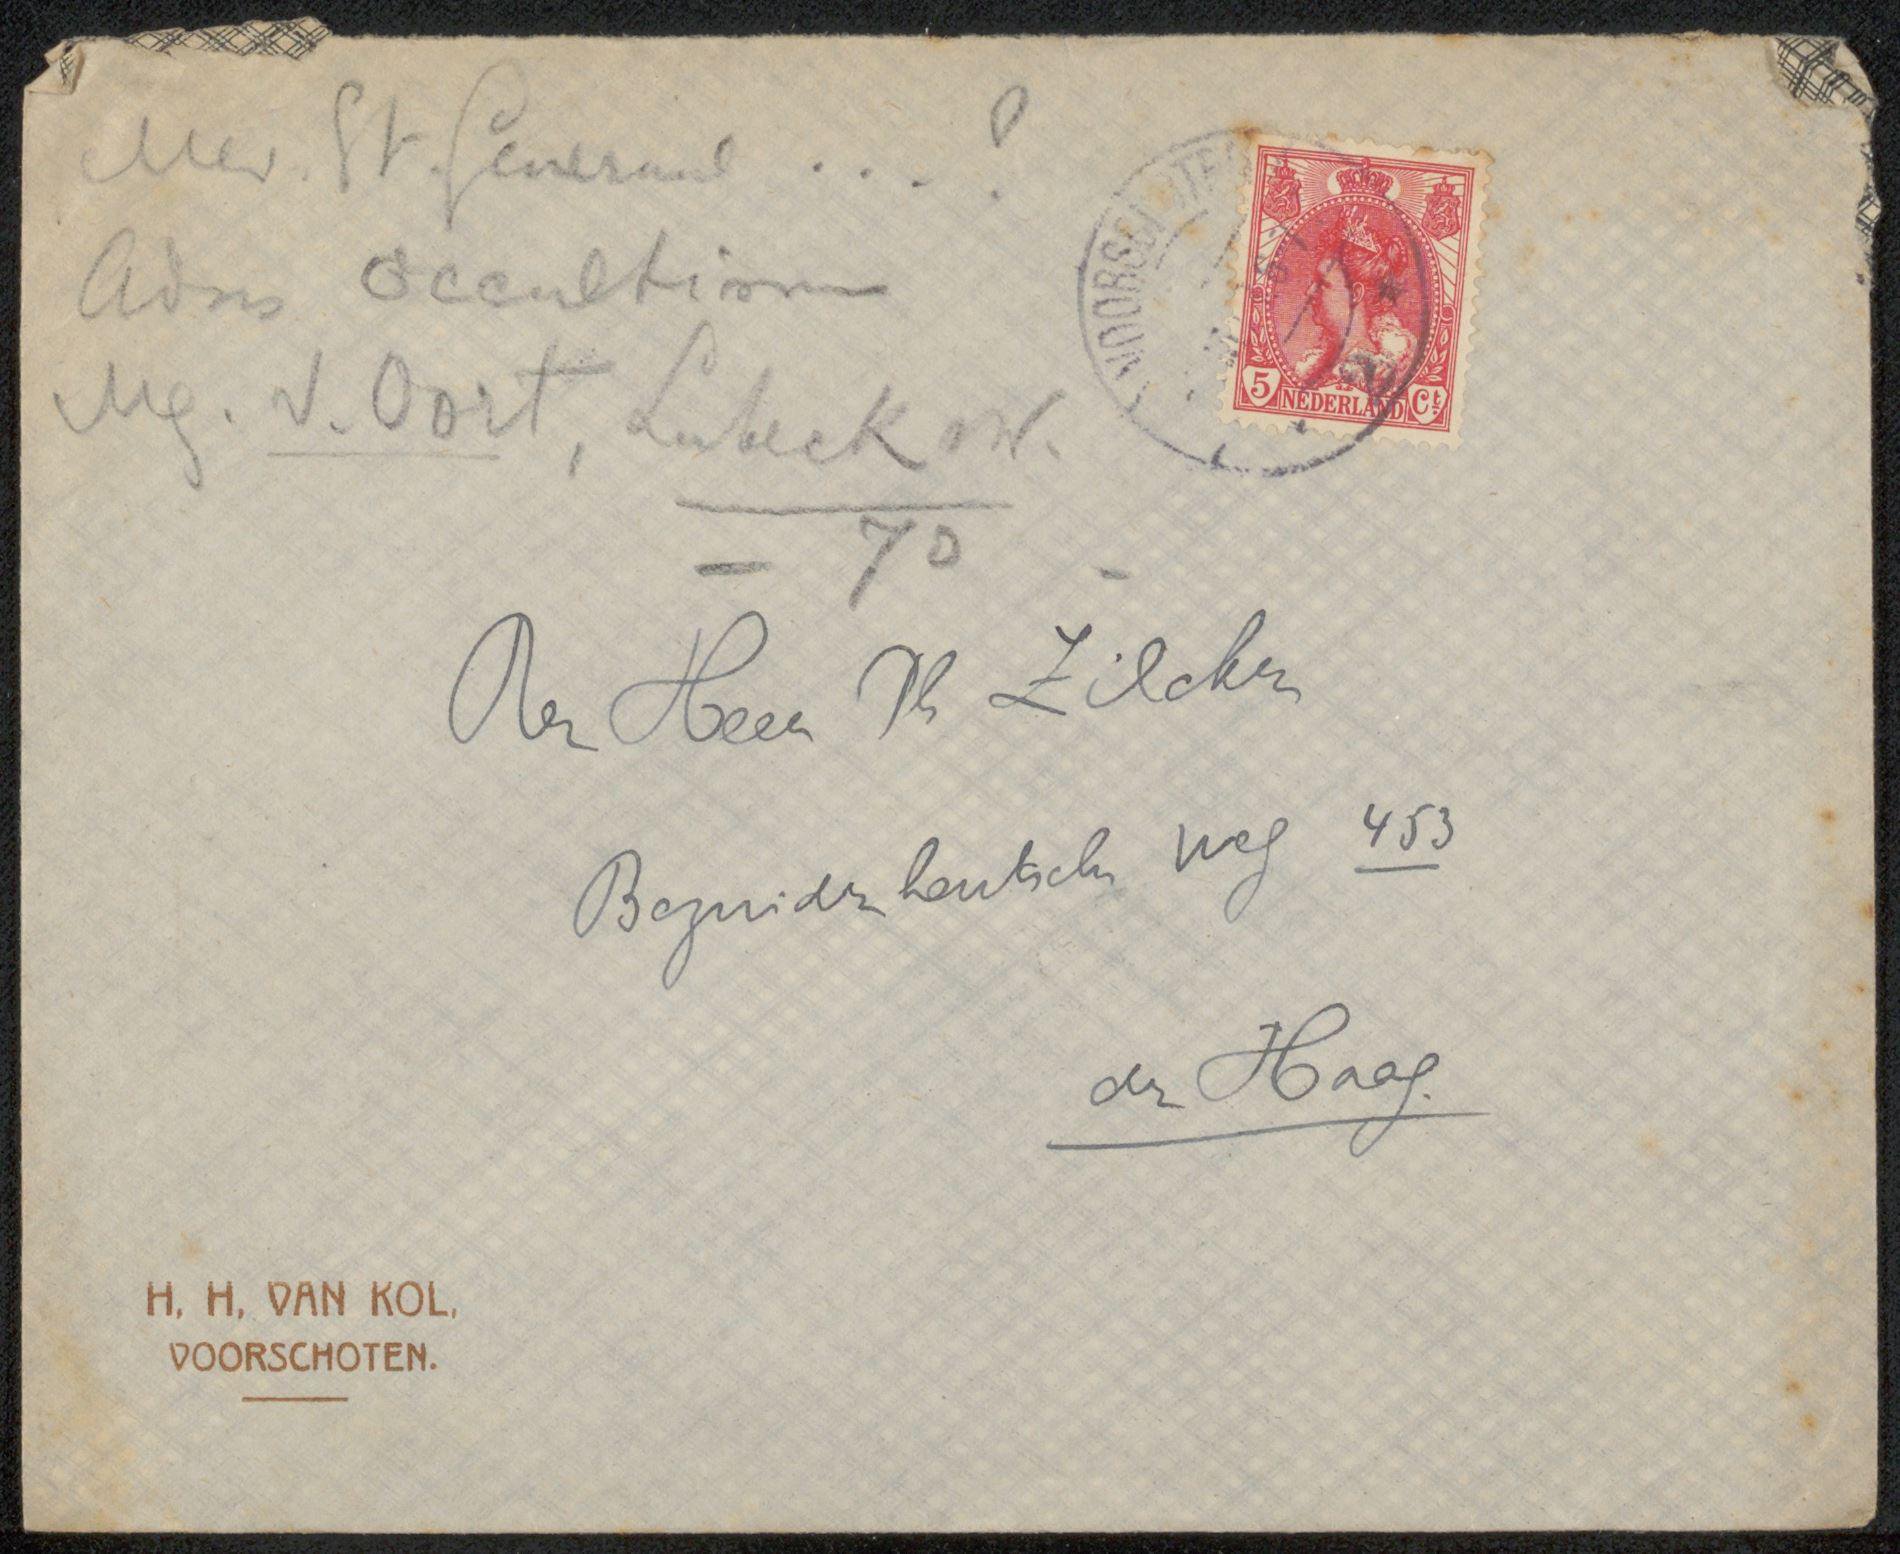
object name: envelope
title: Envelop aan Philip Zilcken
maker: hendrikus hubertus van kol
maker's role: engineer, politician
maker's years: 1852-1925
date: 1862-1925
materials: ink, paper, pencil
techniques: pen, writing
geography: voorschoten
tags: painter, draughtsman, philip zilcken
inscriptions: collector's mark: ‘RPK’, address: ‘H. H. VAN KOL,/ VOORSCHOTEN’